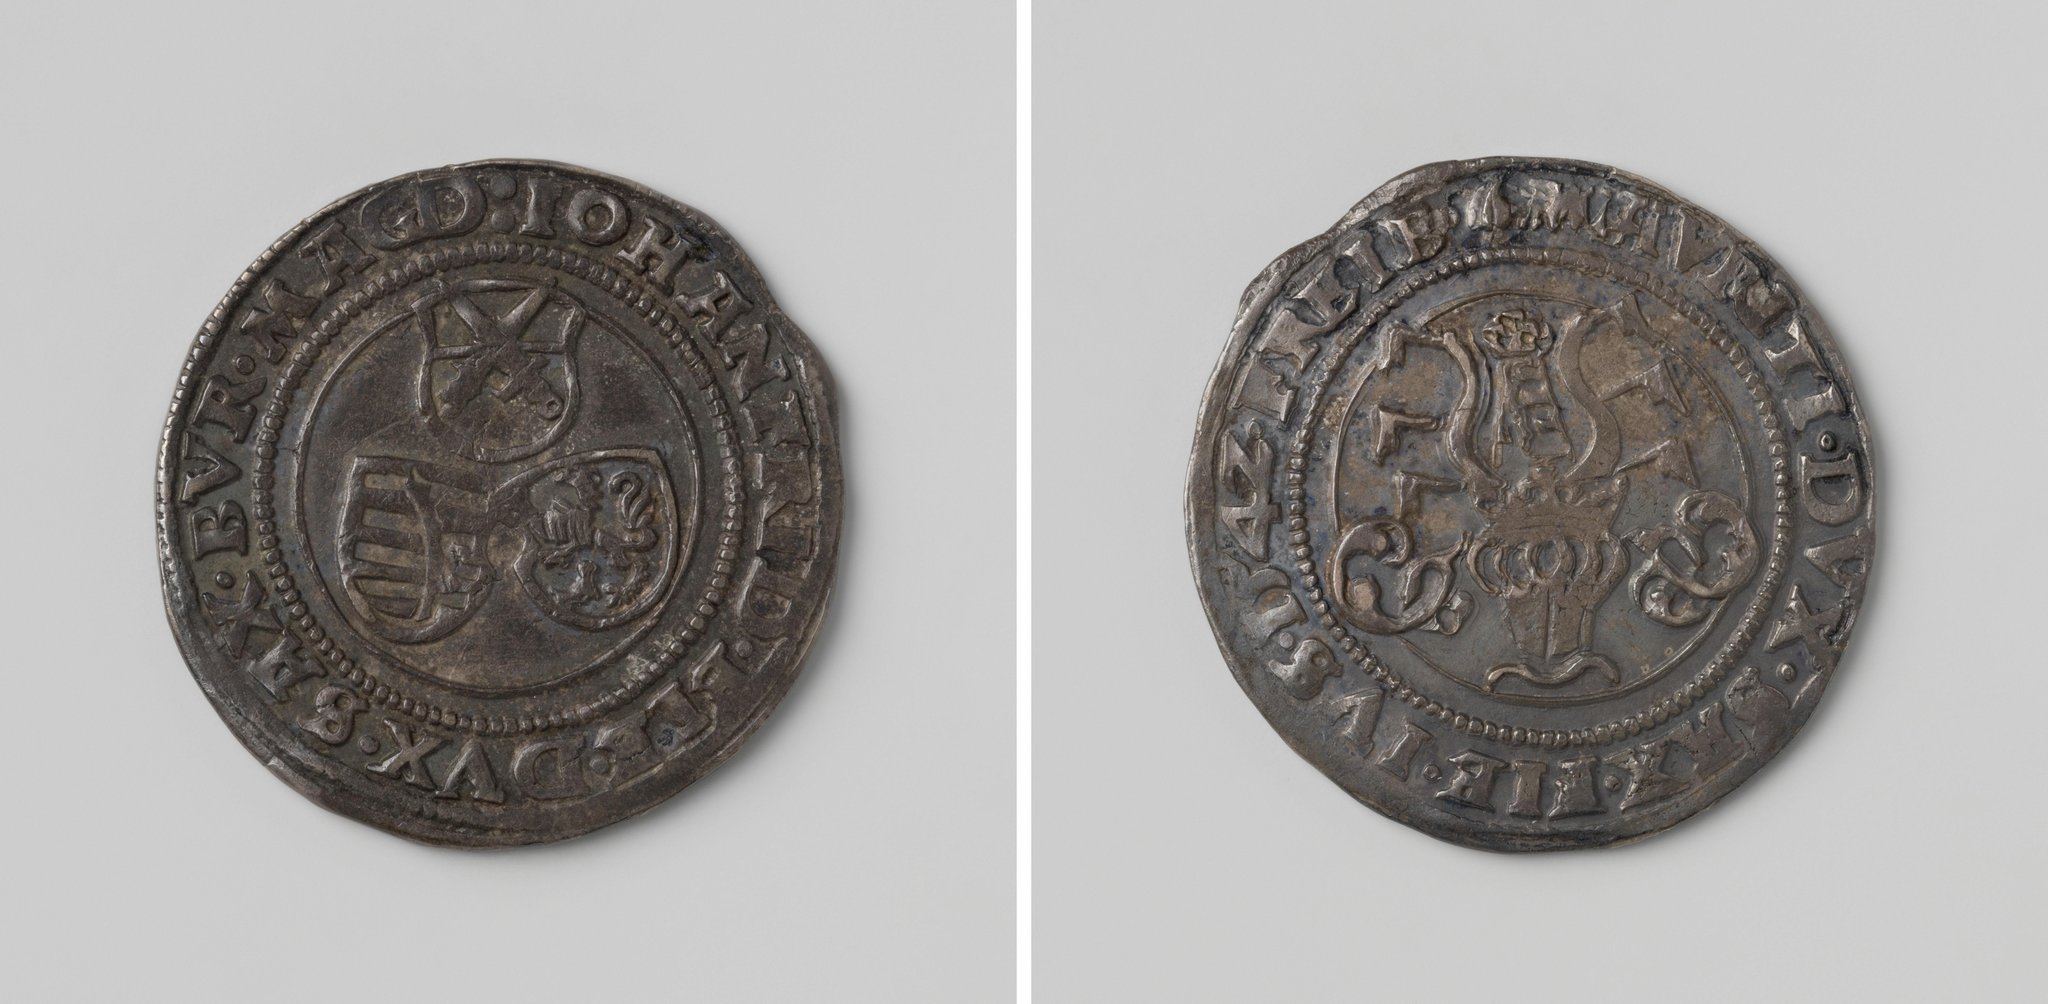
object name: jeton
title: Johan Frederik de Grootmoedige en Maurits, keurvorst en hertog van Saksen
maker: Anonymous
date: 1542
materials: silver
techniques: striking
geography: germany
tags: torgau, weimar, keurvorst, johan frederik i (keurvorst van saksen), sievershausen, keurvorst van saksen maurits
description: Zilveren penning. Voorzijde: wapenschild boven twee andere wapenschilden binnen omschrift. Keerzijde: helm binnen binnen omschrif